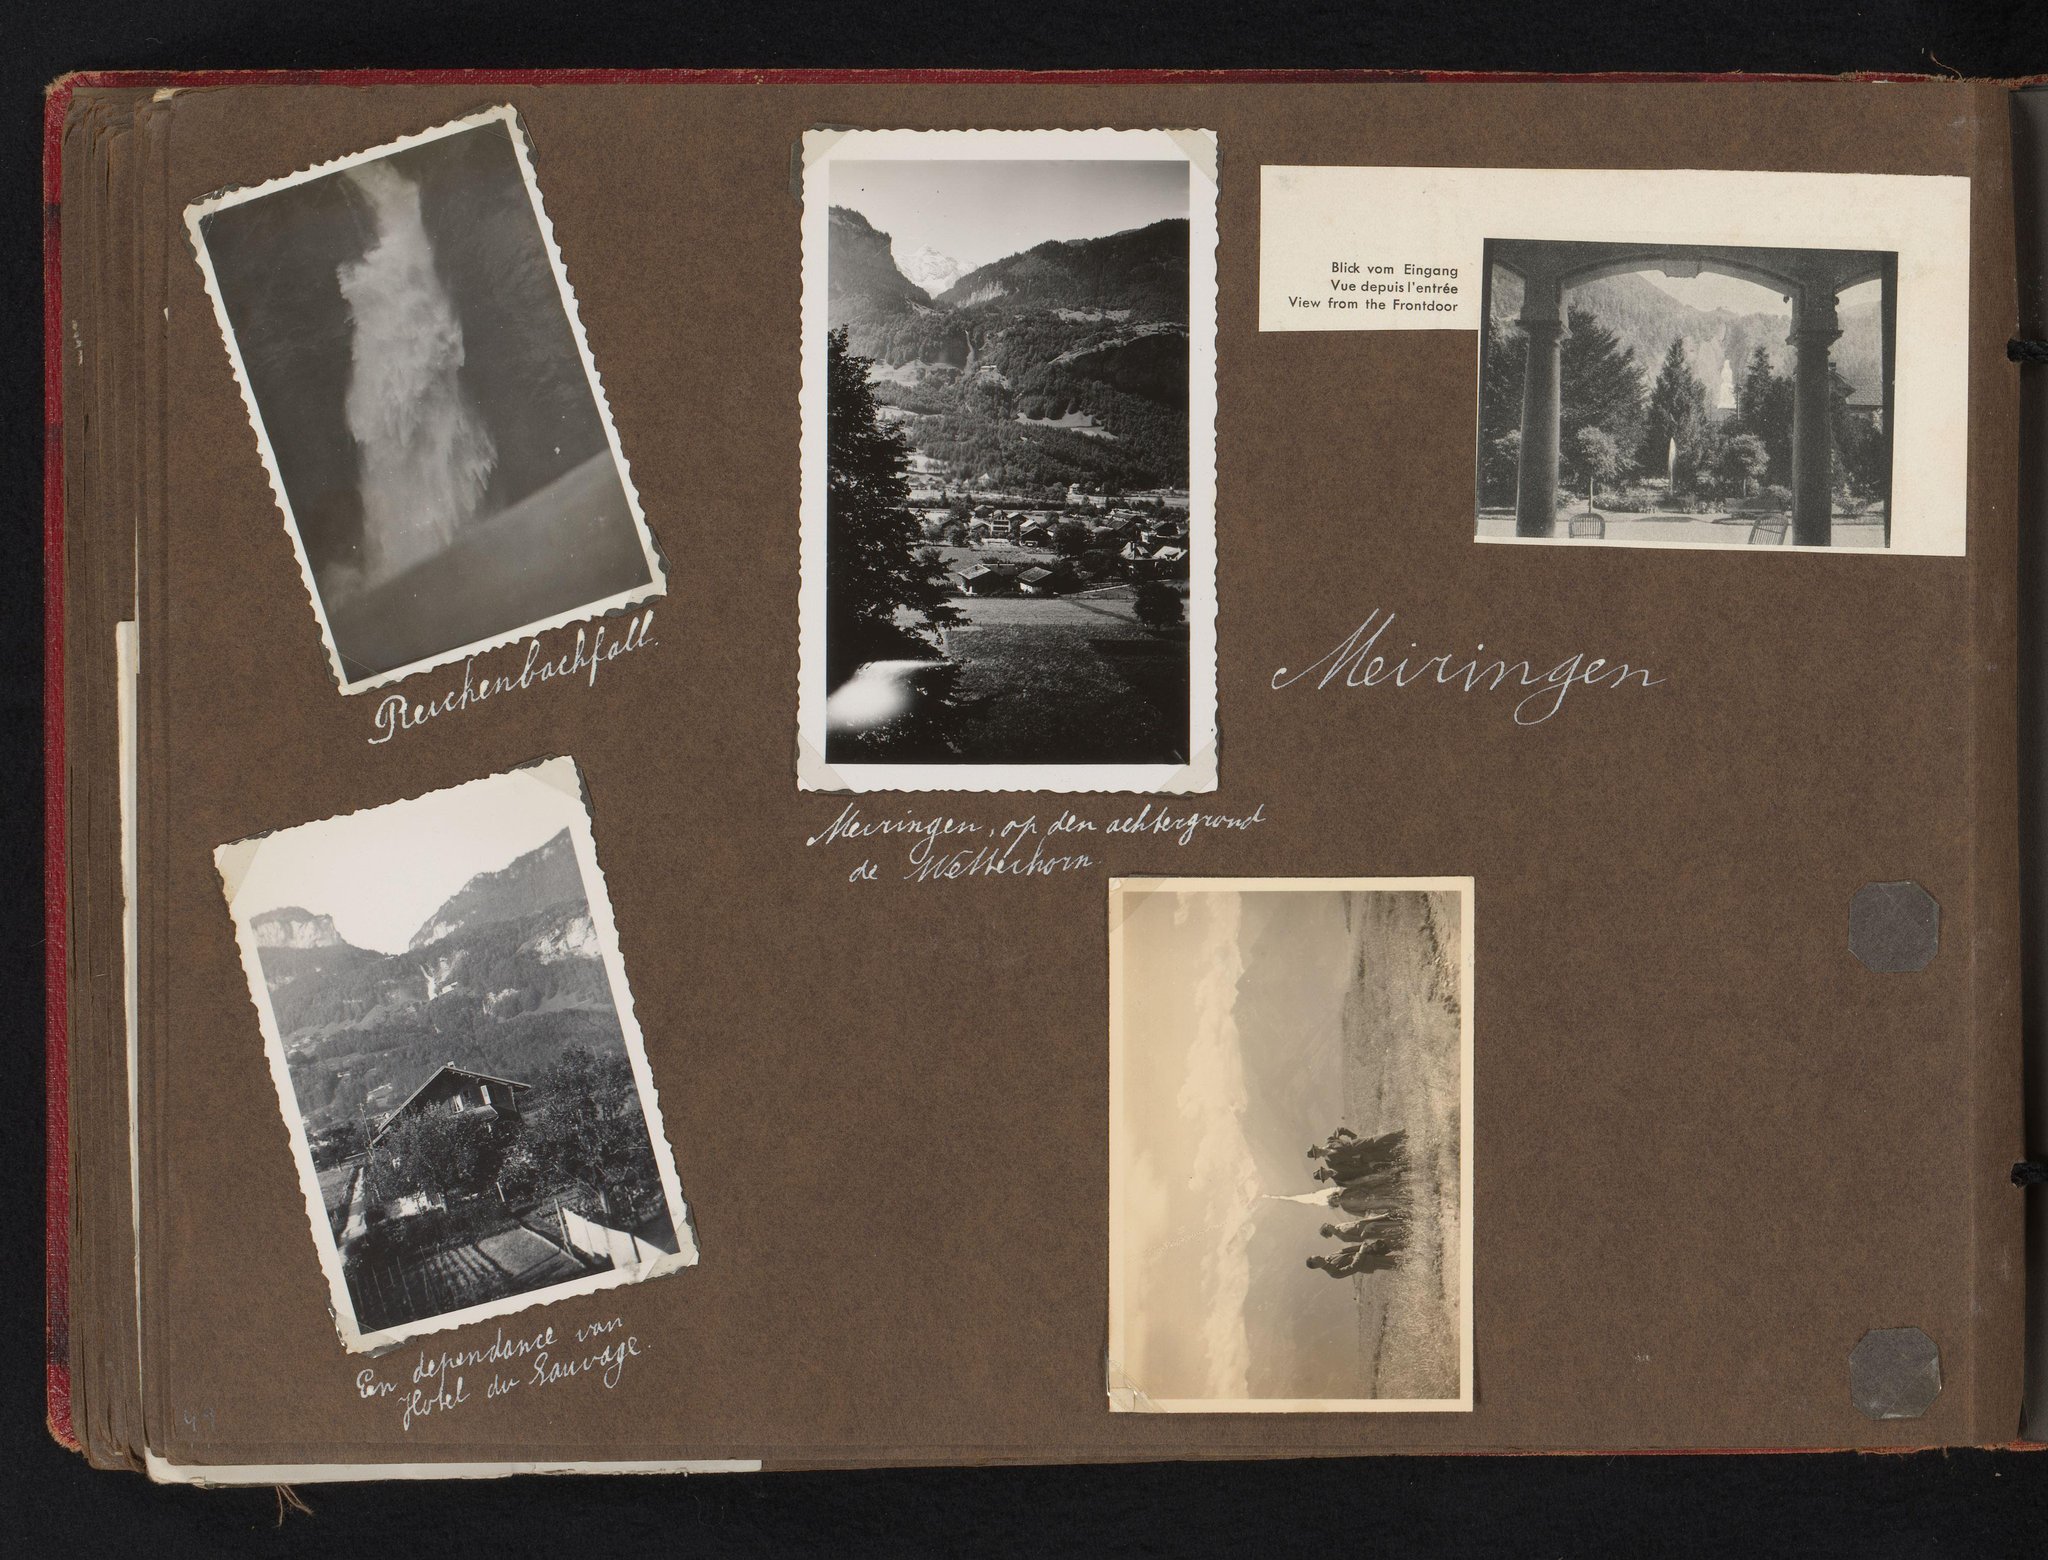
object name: photograph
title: Meiringen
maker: Anonymous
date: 1908-1937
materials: paper, photographic support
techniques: gelatin silver print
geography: switzerland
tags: waterfall, outing, pleasure trip, mountains, switzerland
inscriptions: inscription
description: Albumblad met vier foto's en een afbeelding van landschappen te Meiringen en Reichenbach. Verslag van een elfdaagse groepsreis per autobus naar Zwitserland van 2 tot en met 12 augustus 1937. Onderdeel van het reisalbum van de familie Van den Broek 1935-1937.